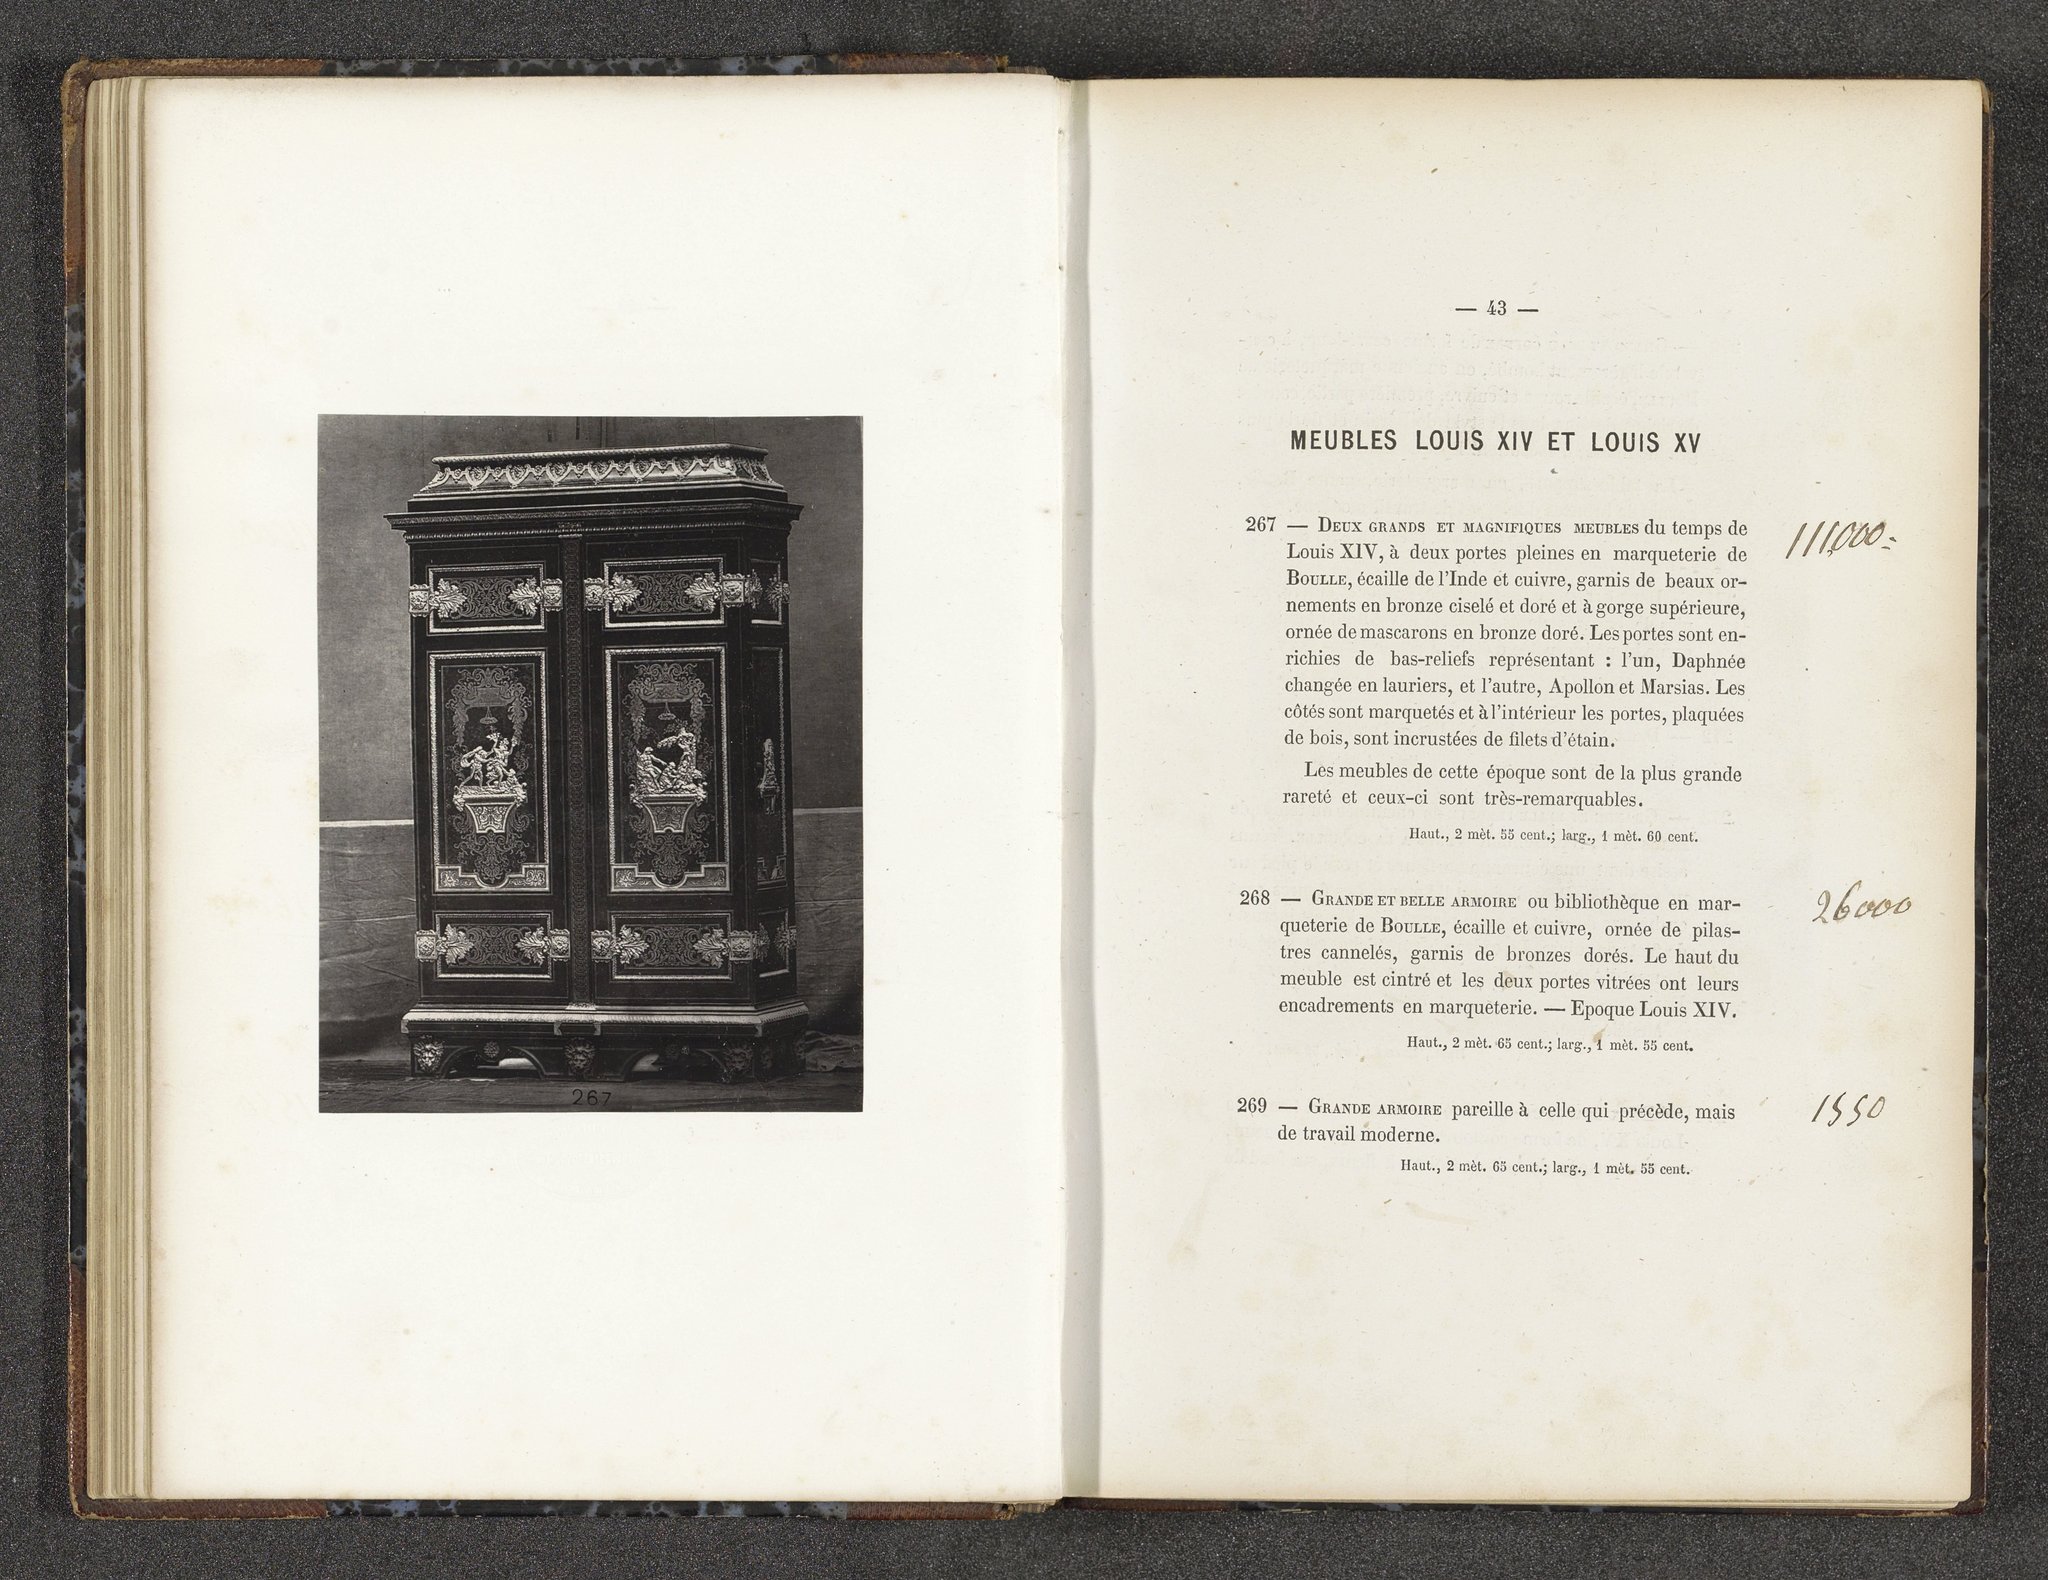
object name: page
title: Kast met op de deuren decoraties van Daphne die transformeert in een laurierboom en Apollo met Marsyas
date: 1870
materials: paper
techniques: woodburytype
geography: paris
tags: ornamental cupboard, (story of) marsyas, daphne changed into a laurel-tree: while fleeing from apollo, daphne is changed into a laurel-tree by her father peneus (ovid, metamorphoses i 548)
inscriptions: number: ‘267’, name: ‘De Goupil & Cie Imp. Photoglytique Paris’